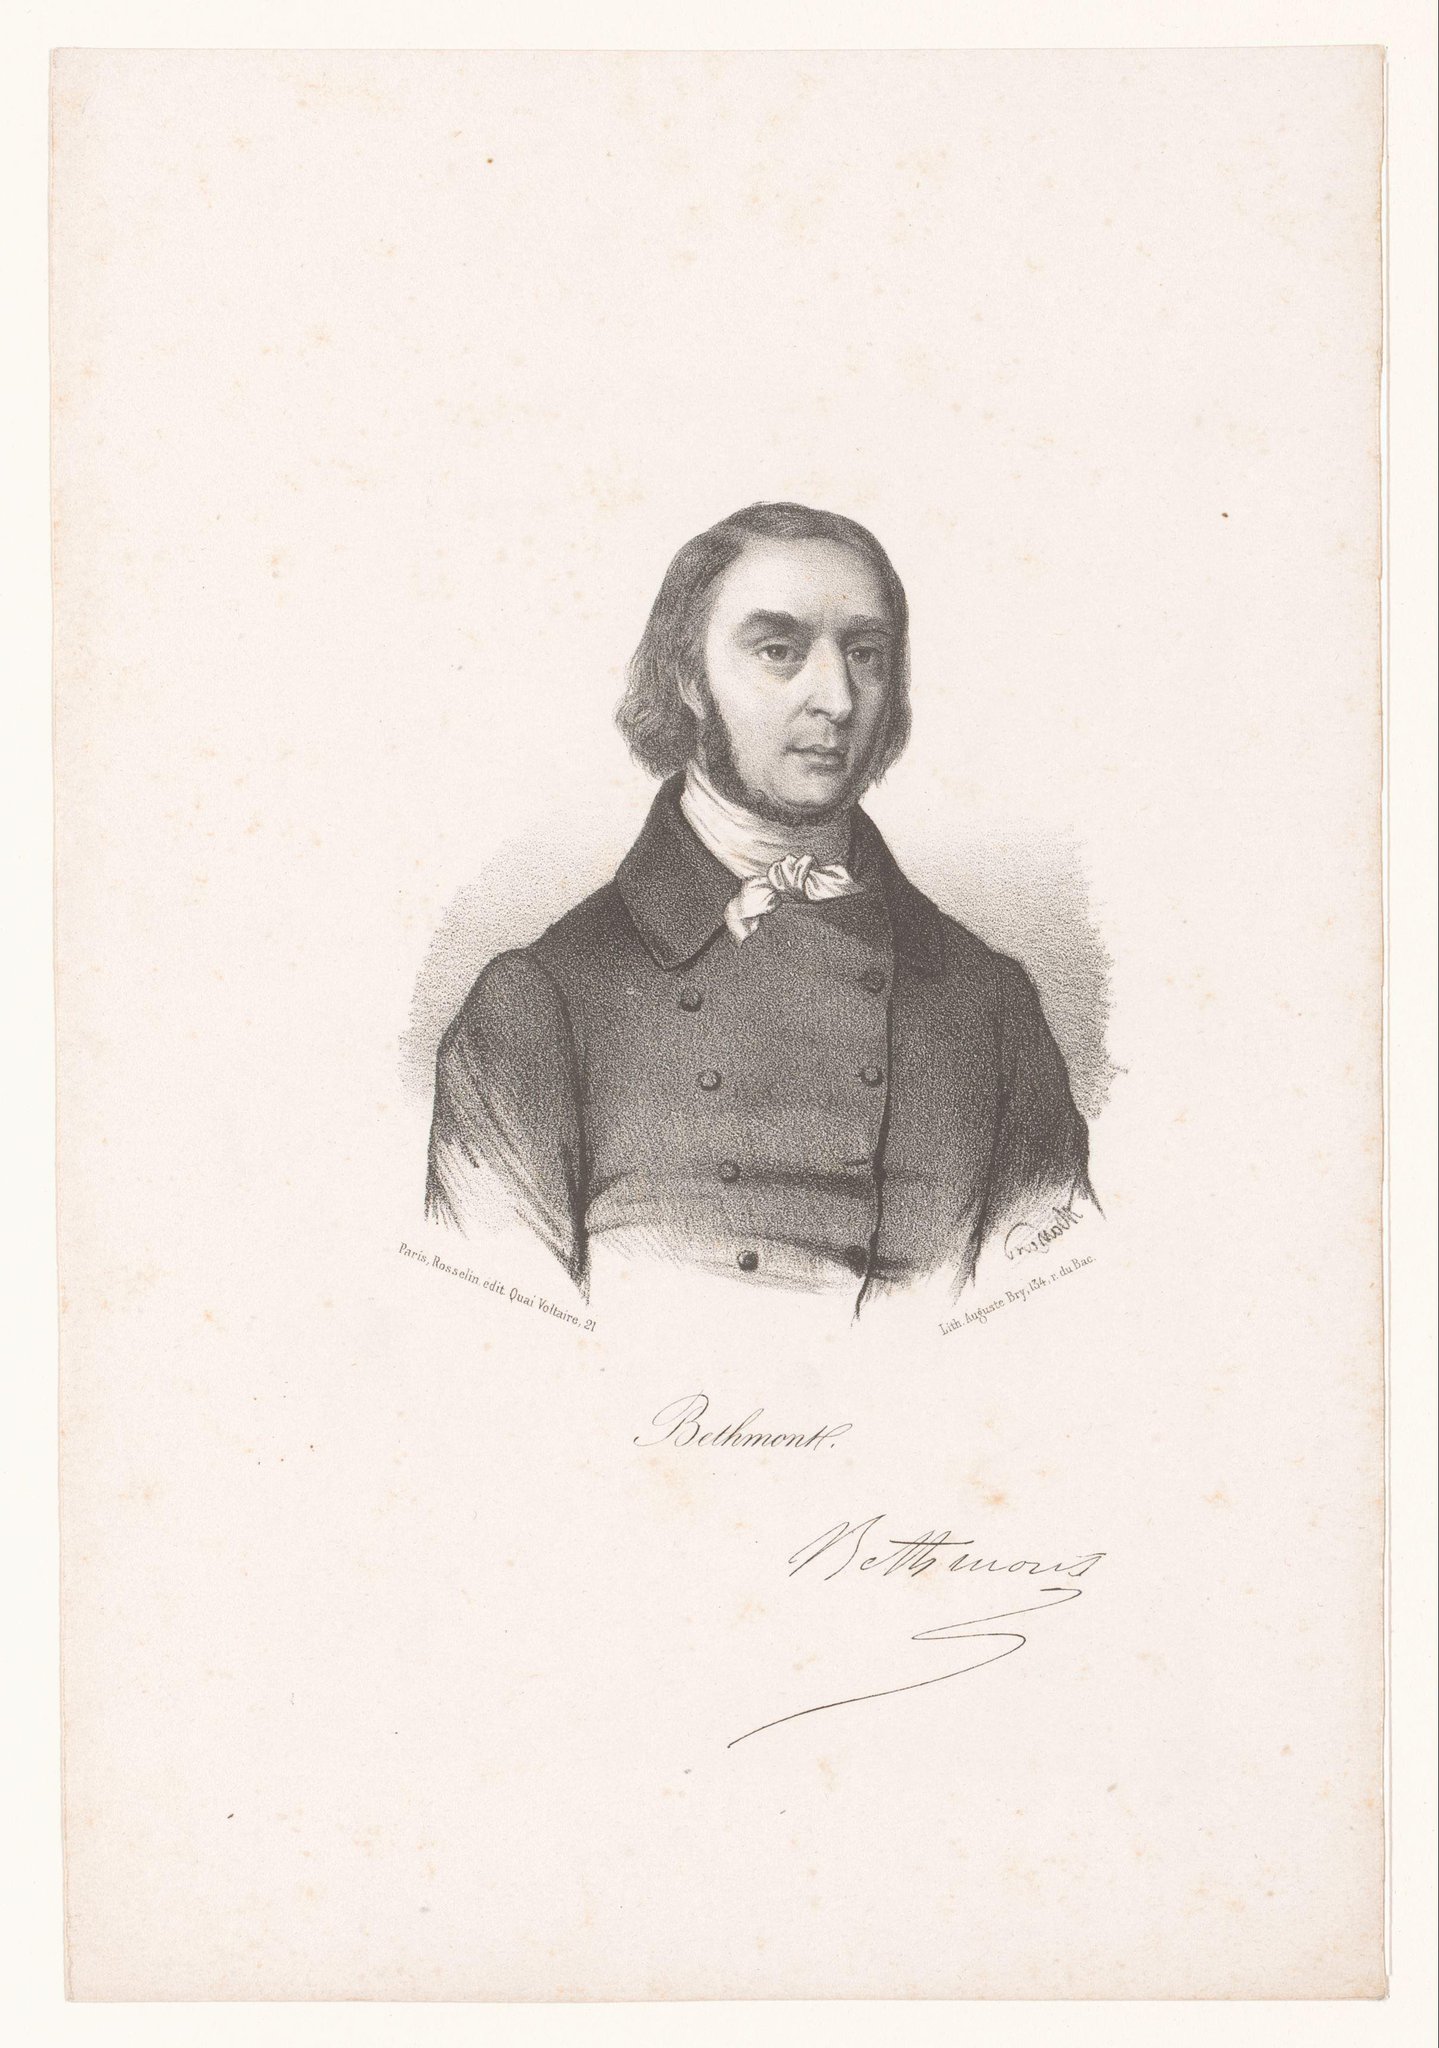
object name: print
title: Bethmont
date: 1848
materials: paper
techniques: lithograph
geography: paris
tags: paris, politician, historical persons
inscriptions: collector's mark: Lugt 2228